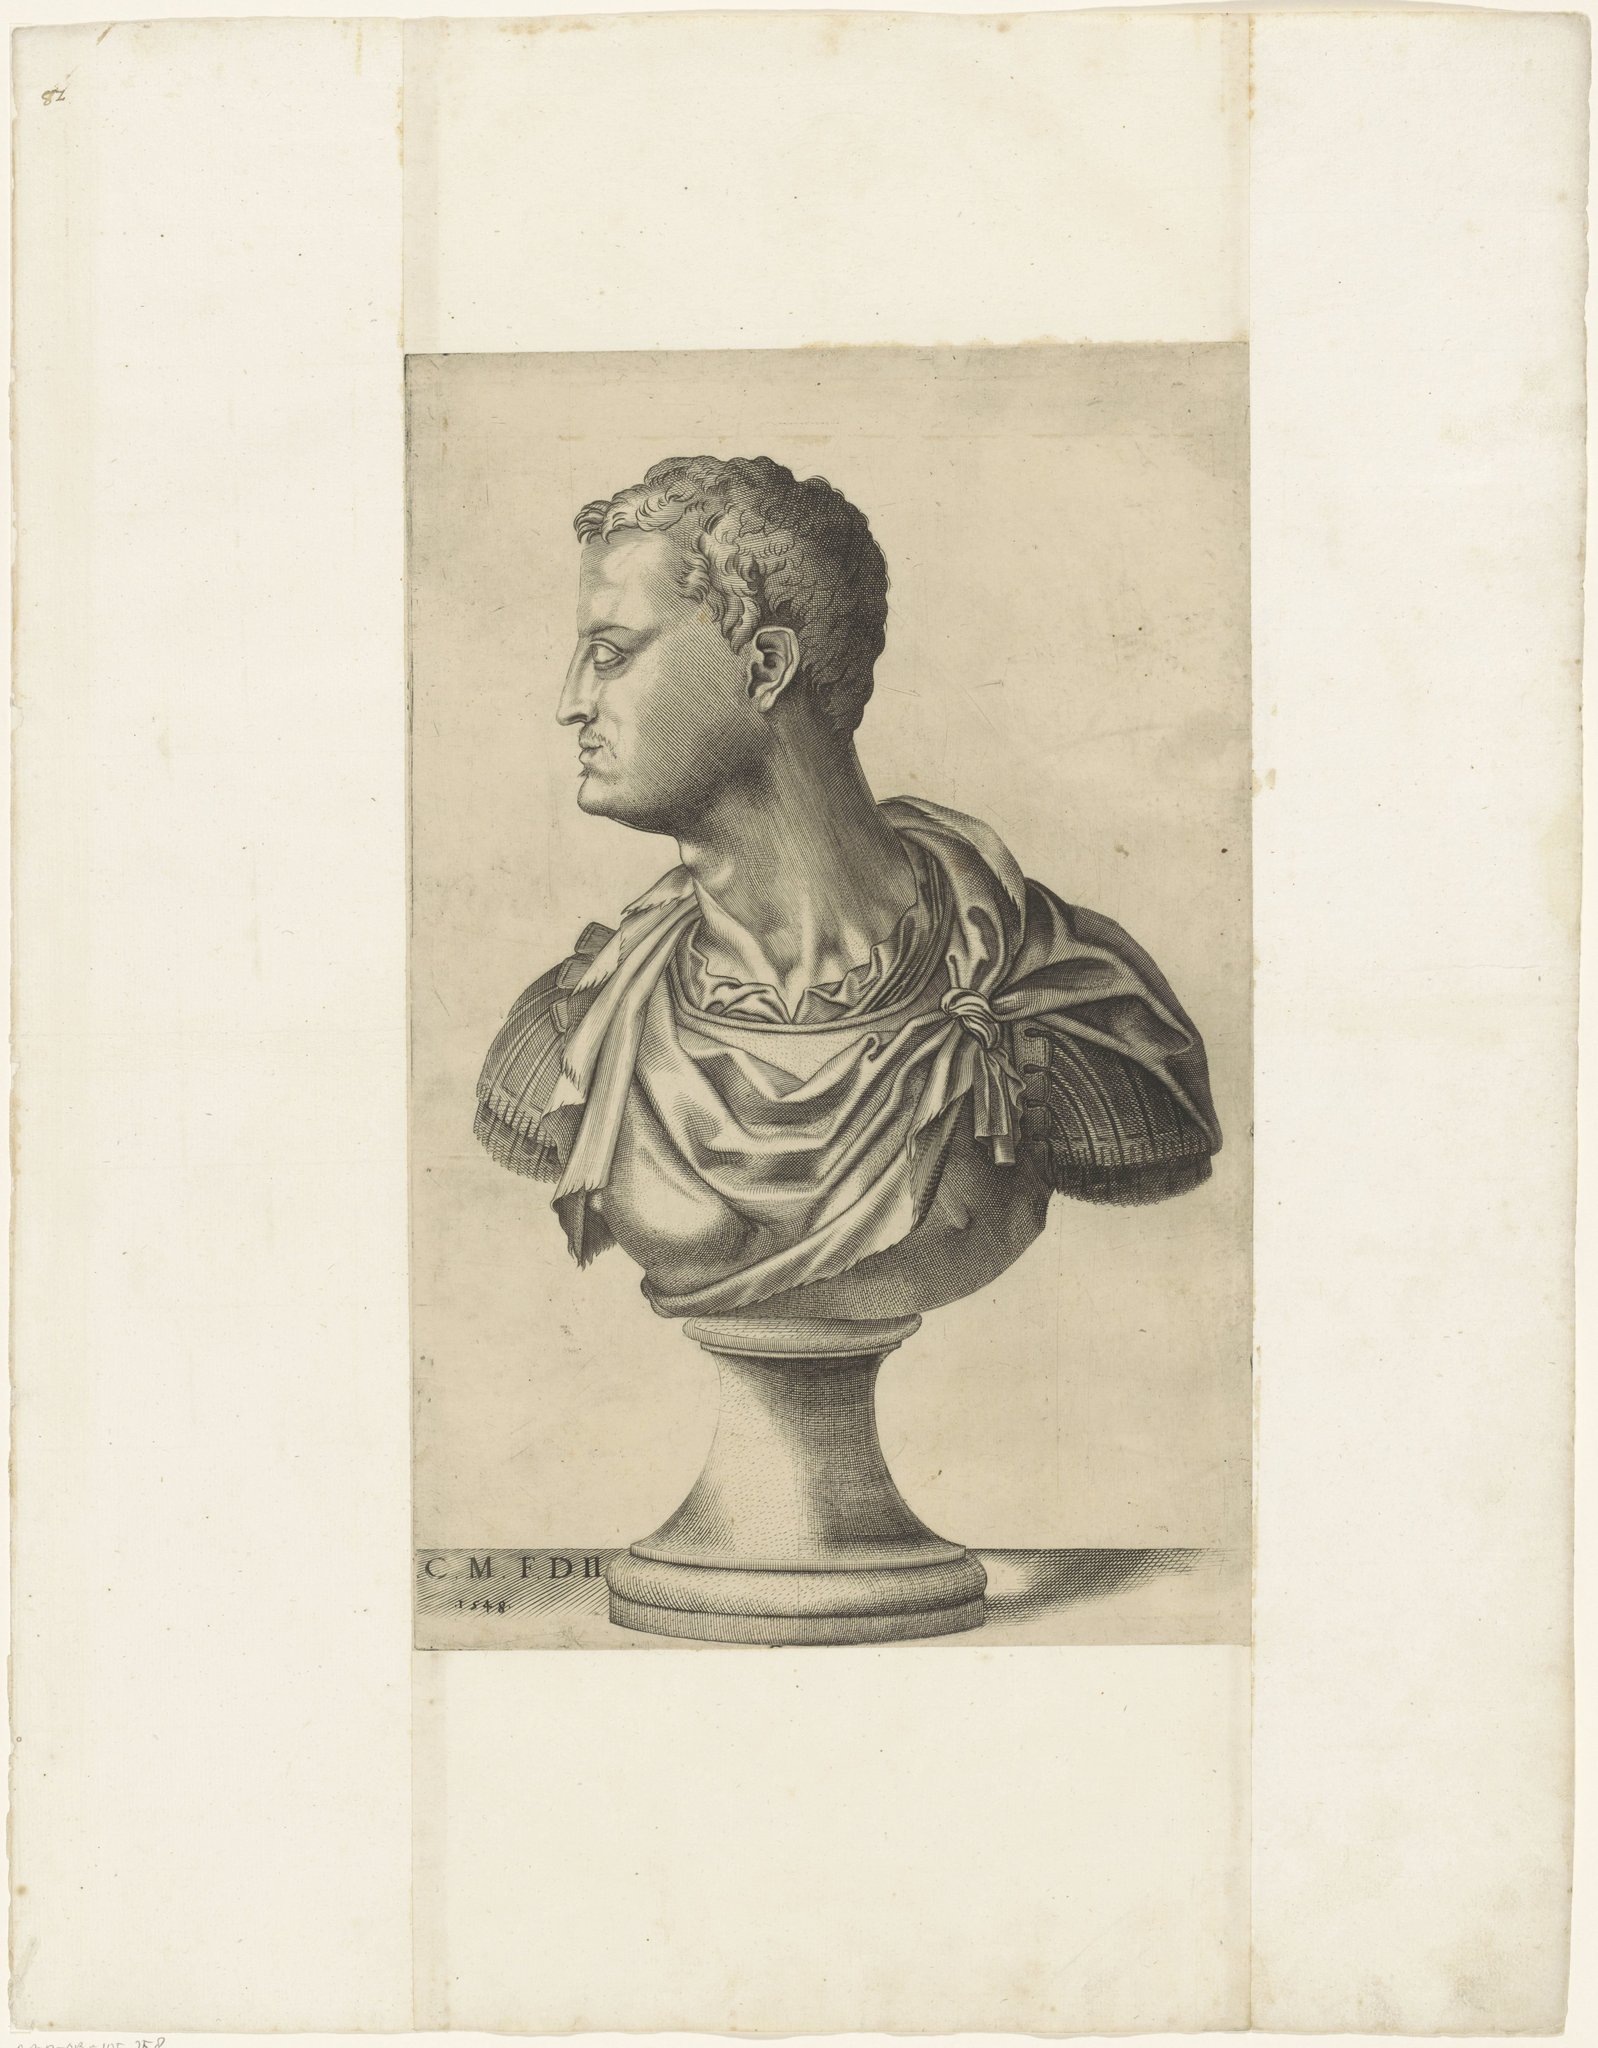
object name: print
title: Portret van Cosimo I de’ Medici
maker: Anonymous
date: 1548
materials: paper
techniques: engraving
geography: italy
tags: cosimo i de' medici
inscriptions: watermark, collector's mark: Lugt 2760, number: ‘82’, collector's mark: Lugt 2228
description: Folio 82 uit het prentalbum van Johann Georg I. Zobel von Giebelstadt (Röttingen 1543-07-20 - Bamberg 1580-09-07), de latere bisschop van Bamberg. Het album is vermoedelijk samengesteld tussen 1568 en 1570 in Venetië. Het album werd in 1999 uit elkaar genomen door een antiquair. De in totaal 124 folio's met prenten uit het "Zobel Album" werden aangekocht door verschillende musea en privéverzamelingen. De grootste groep (68 folio's) bevindt zich in de collectie van het Rijksmuseum.